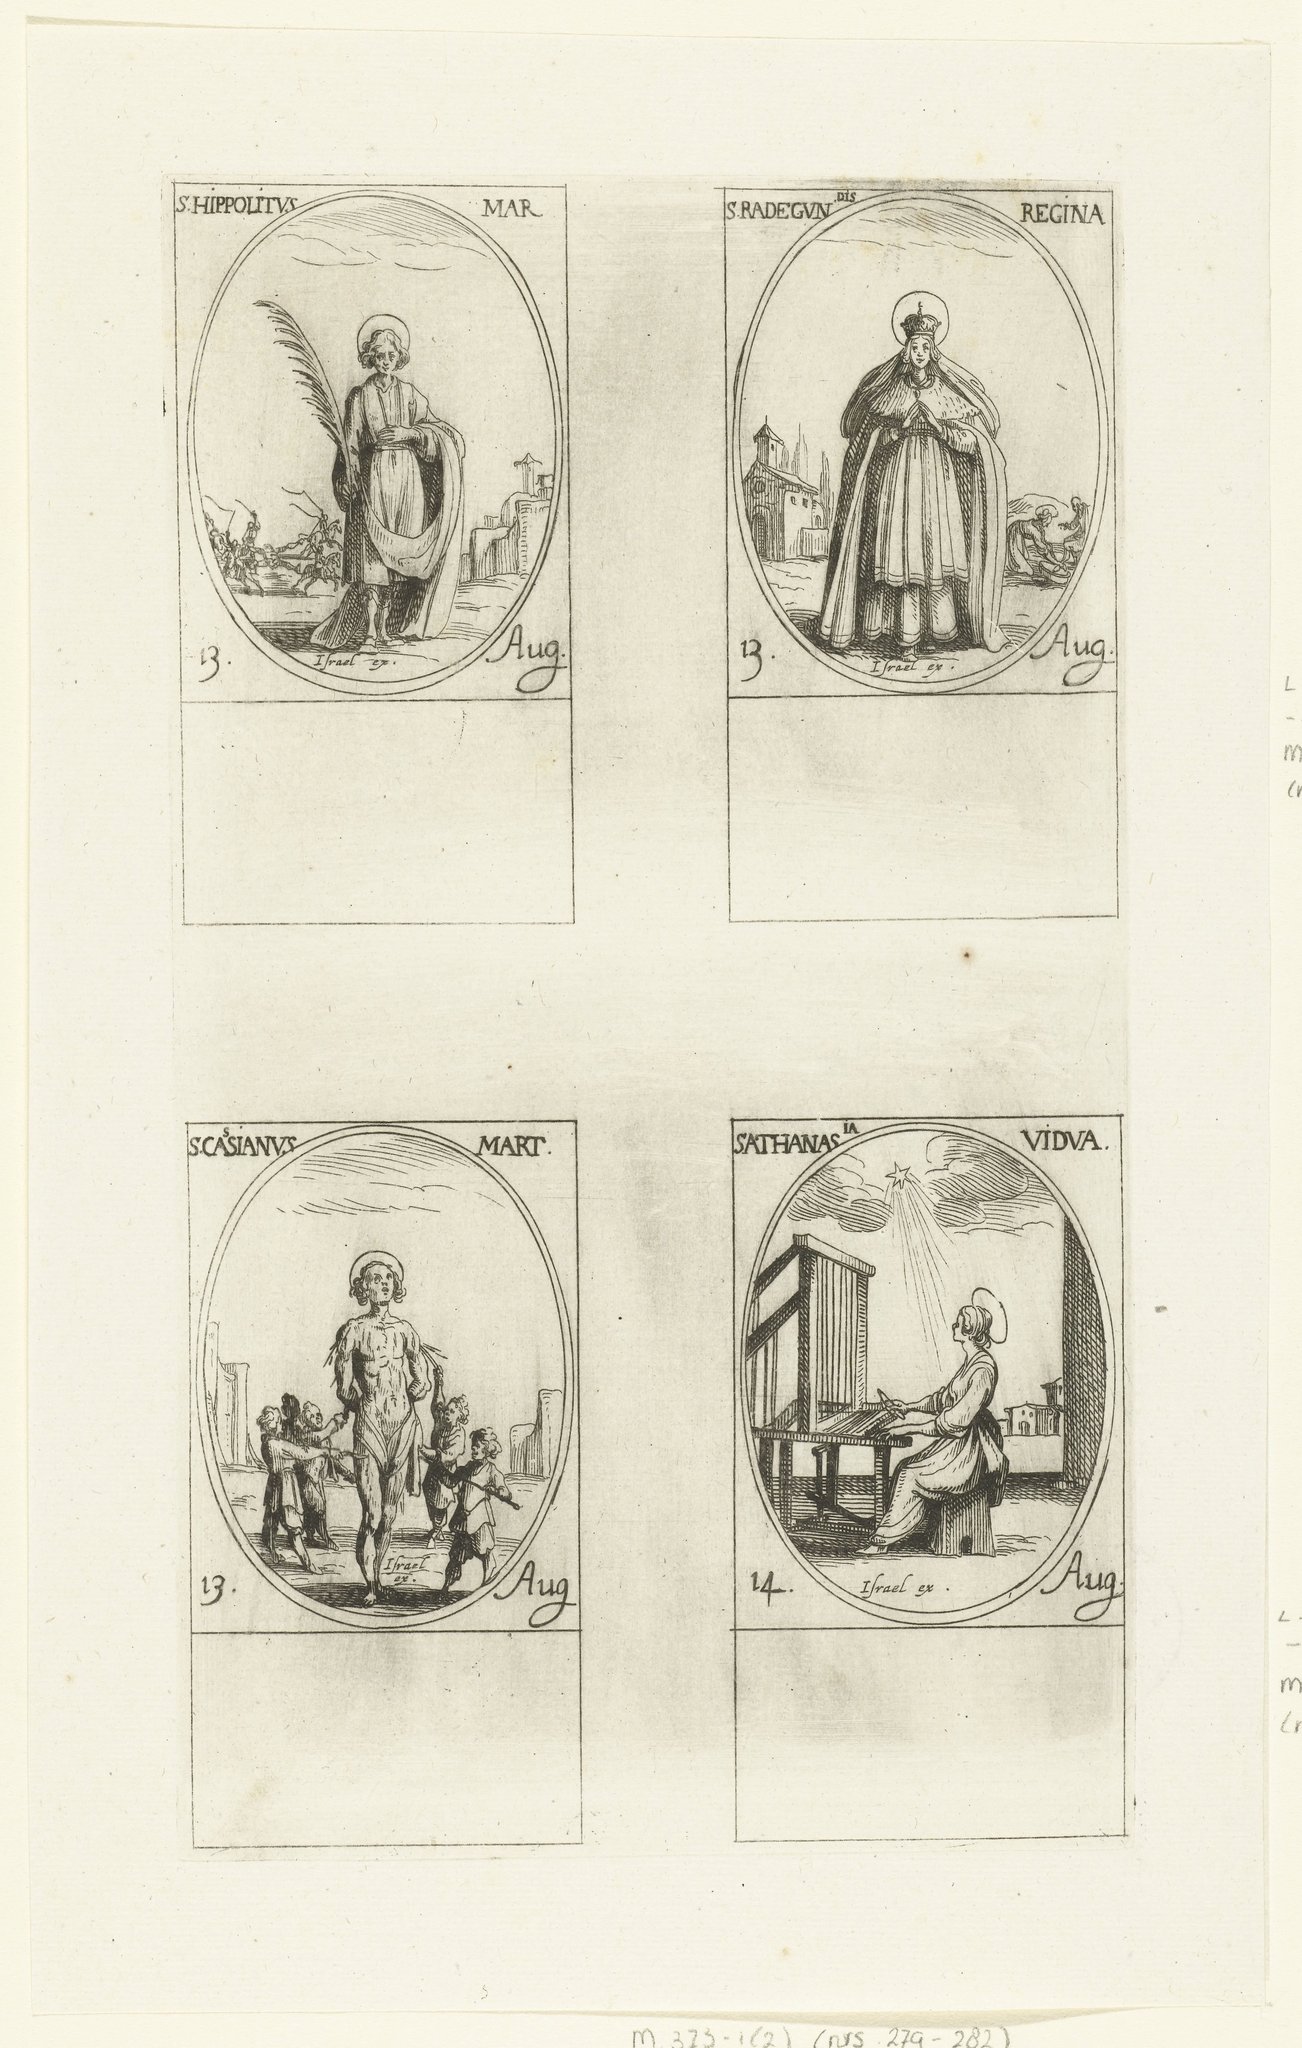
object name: print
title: Alle heiligen en de Christelijke feestdagen van het jaar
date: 1632-1636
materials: paper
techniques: etching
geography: nancy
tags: female saints (with name), st. cassian's pupils kill him with their iron styles, the soldier, martyr and gaoler hippolytus; possible attributes: hackle, key, rope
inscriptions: collector's mark: Lugt 240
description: Blad met vier ovale voorstellingen, elk met opschrift en datum in het Latijn: linksboven de Heilige Hippolytus van Rome met een palmtak, rechtsboven de Heilige Radegundis van Poitiers in koningsmantel en met een kroon op het hoofd, linksonder de Heilige Cassianus van Imola die door kinderen met o.a. schrijfgerei wordt gestoken, rechtsonder de Heilige Athanasia van Aegina achter een weefgetouw. Deze prent is onderdeel van een serie prenten met voorstellingen van de heiligen en de christelijke feestdagen van het jaar. Er zijn steeds vier scènes van één plaat op één blad gedrukt. Inclusief bijbehorend titelblad en frontispice gaat het in totaal om 124 platen (490 voorstellingen). De drie platen met de laatste 12 scènes (de veranderlijke christelijke feestdagen) zijn in de derde staat versneden tot 12 kleine plaatjes, en met een apart titelblad uitgegeven.